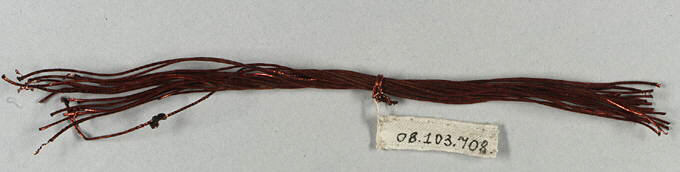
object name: thread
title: Tinsel and metal thread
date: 1601-1800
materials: metal thread